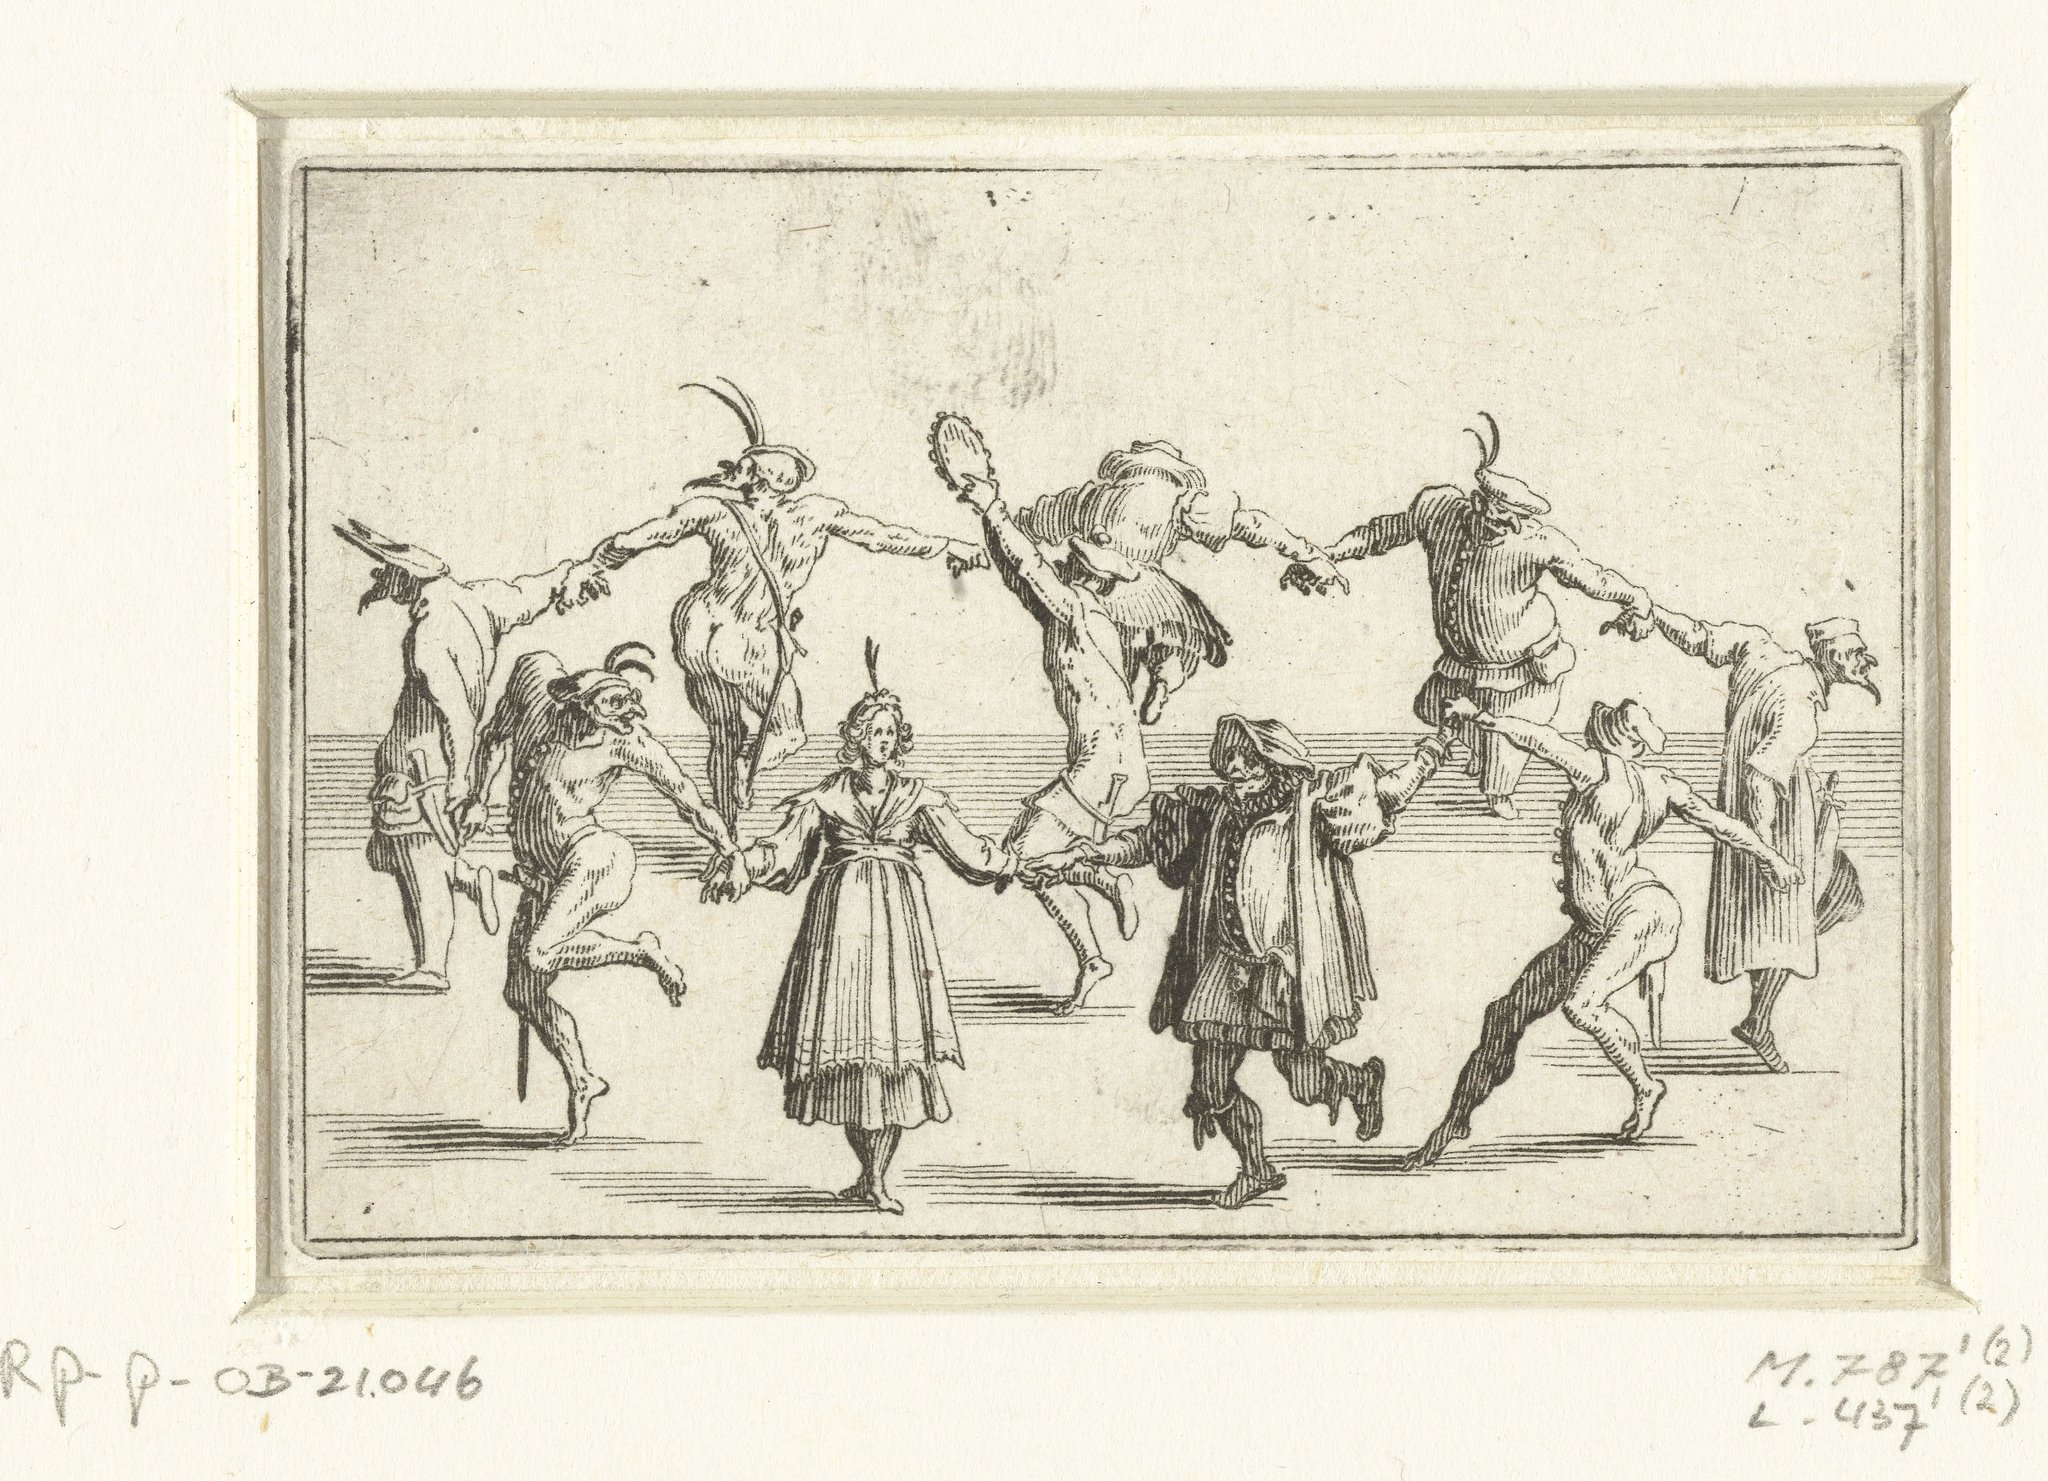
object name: print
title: Capricci di varie Figure di Jacopo Callot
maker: jacques callot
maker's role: draughtsman, print maker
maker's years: 1592-1635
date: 1621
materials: paper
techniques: etching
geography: nancy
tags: types in 'commedia dell'arte', tambourine, group dancing around someone or something (folk dancing)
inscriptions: collector's mark: Lugt 240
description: Callot maakte een eerste versie van de prentserie 'Capricci di varie Figure' in Florence rond 1617. Omdat deze in relatief zachte koperplaten was geëtst en snel sleet, maakte hij een tweede in Nancy in 1621. De twee versies zijn slechts op details van elkaar te onderscheiden. De reeks die het Rijksmuseum bezit, bestaat op 1 prent (RP-P-OB-21.081) na uit Franse exemplaren d.d. 1621. Klinkert, C.